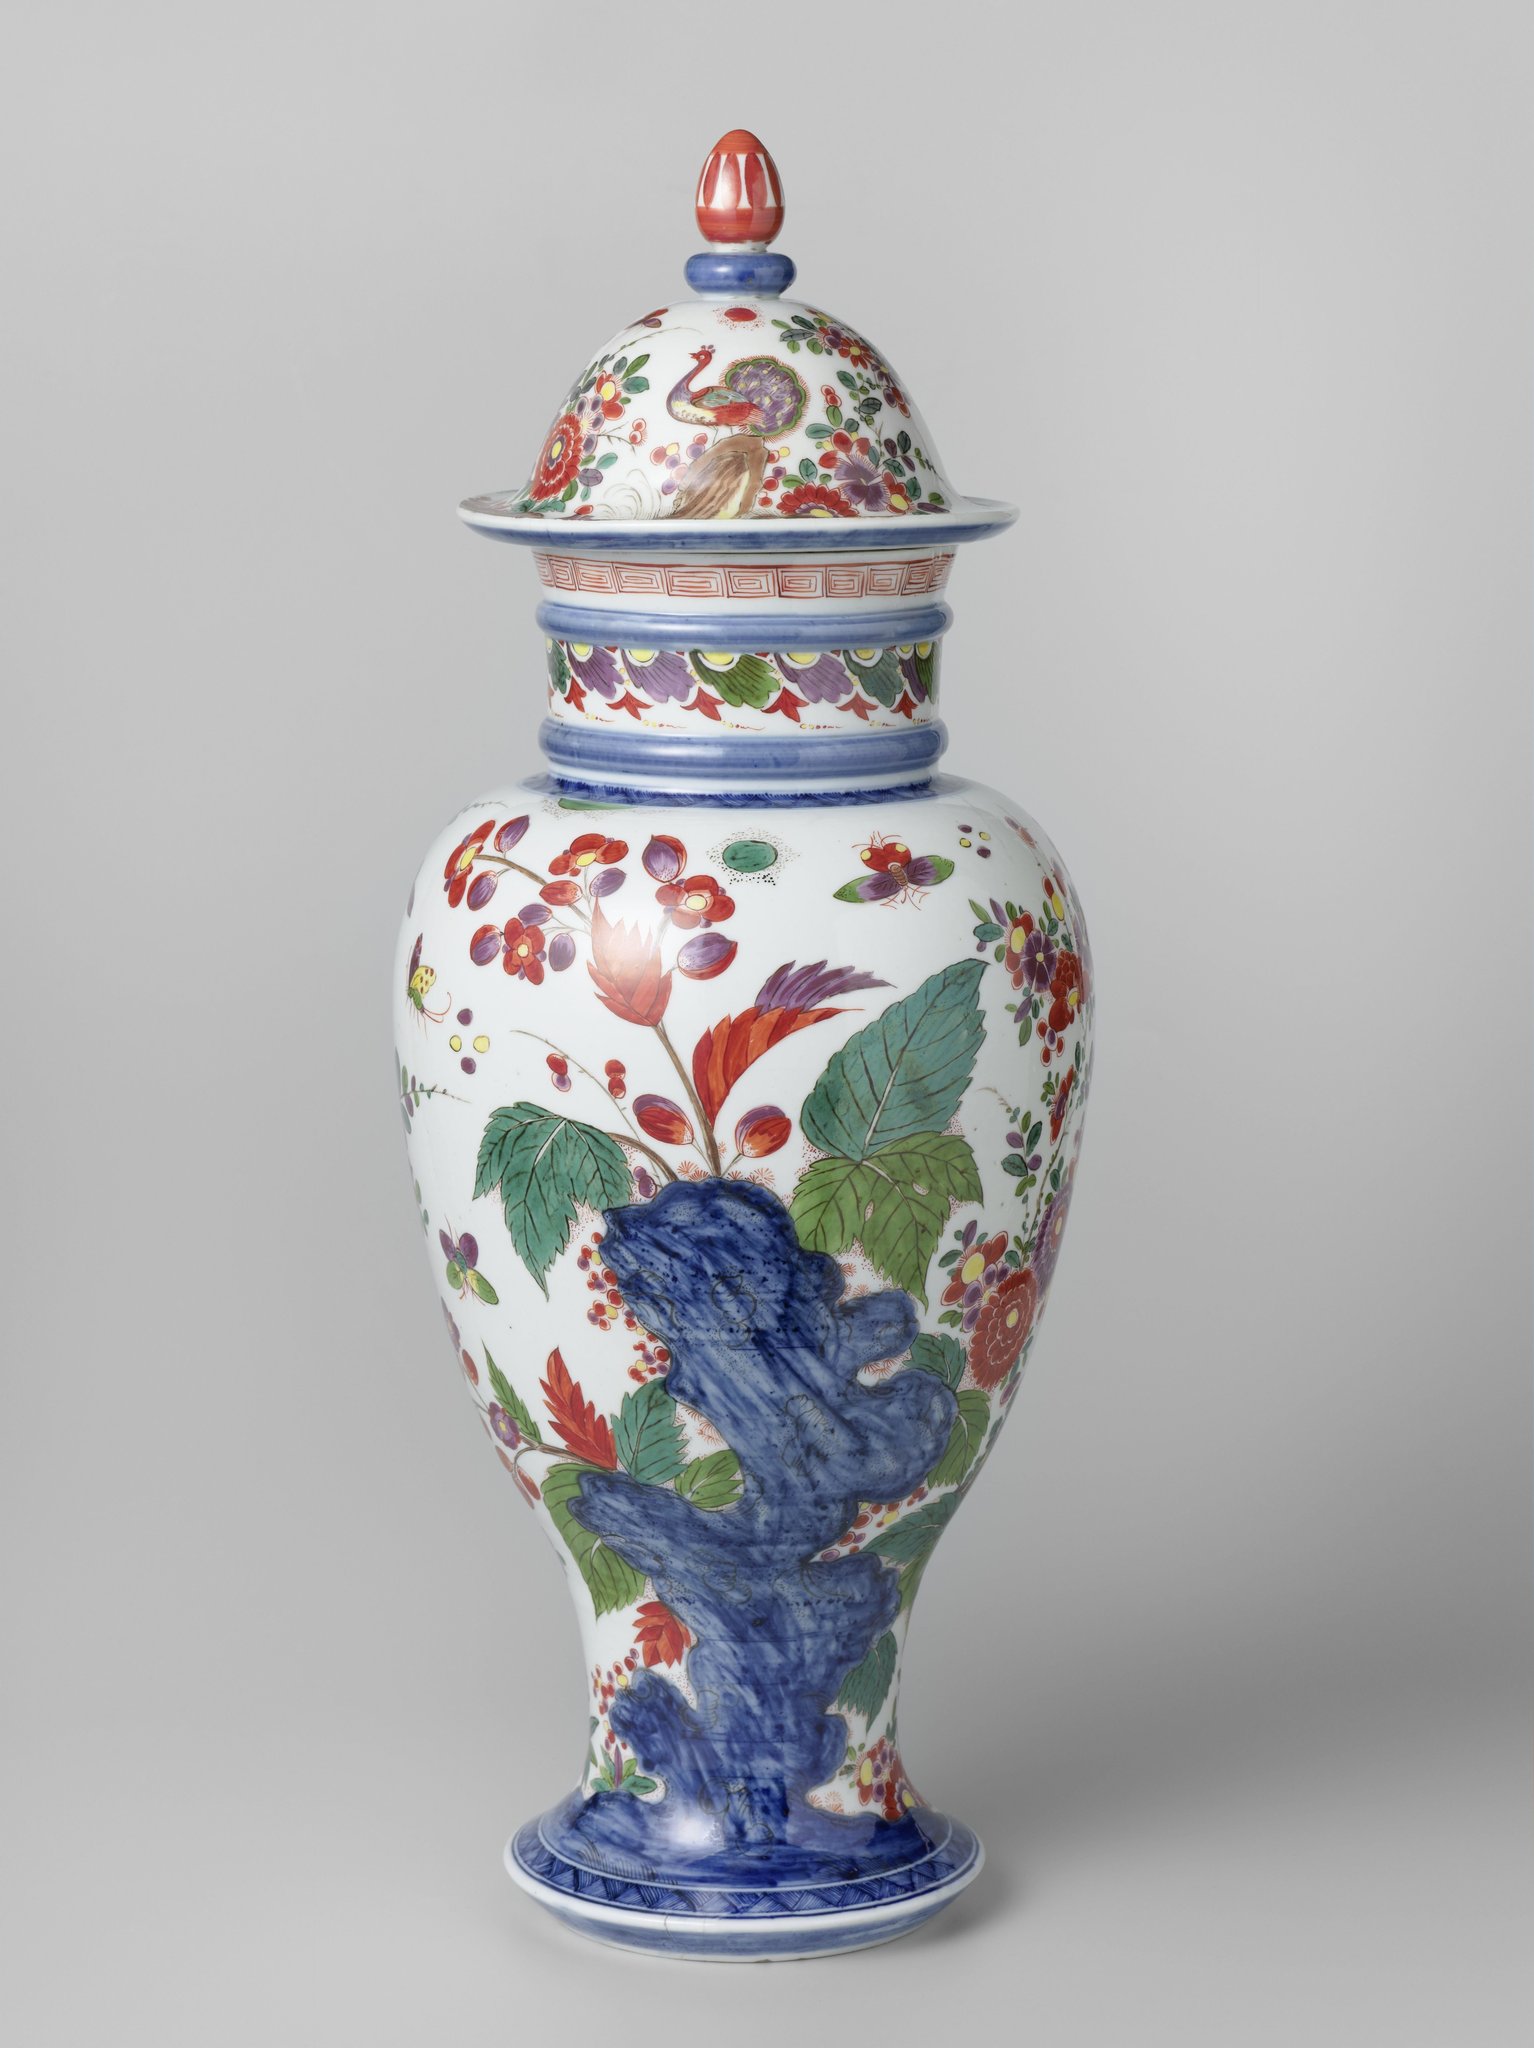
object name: decoratief object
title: Lidded vase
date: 1725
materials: porcelain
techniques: painted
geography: meissen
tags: flowers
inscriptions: factory mark: ‘AR’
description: Vaas van veelkleurig beschilderd porselein. De vaas heeft een voet, een hoge hals door twee ringen geleed en een deksel met een knop. Op de vaas is een rots geschilderd van waaruit een dikke tak met veelkleurige Indianische Blumen en kleinere bloeiende takken ontspringen. Op het lichaam verspreid insekten, tussen de ringen op de hals een bloemenfries en langs de mondrand een meander in rood. Het deksel is beschilderd met veelkleurige Indianische Blumen en een pauw op een rots. De vaas is gemerkt.